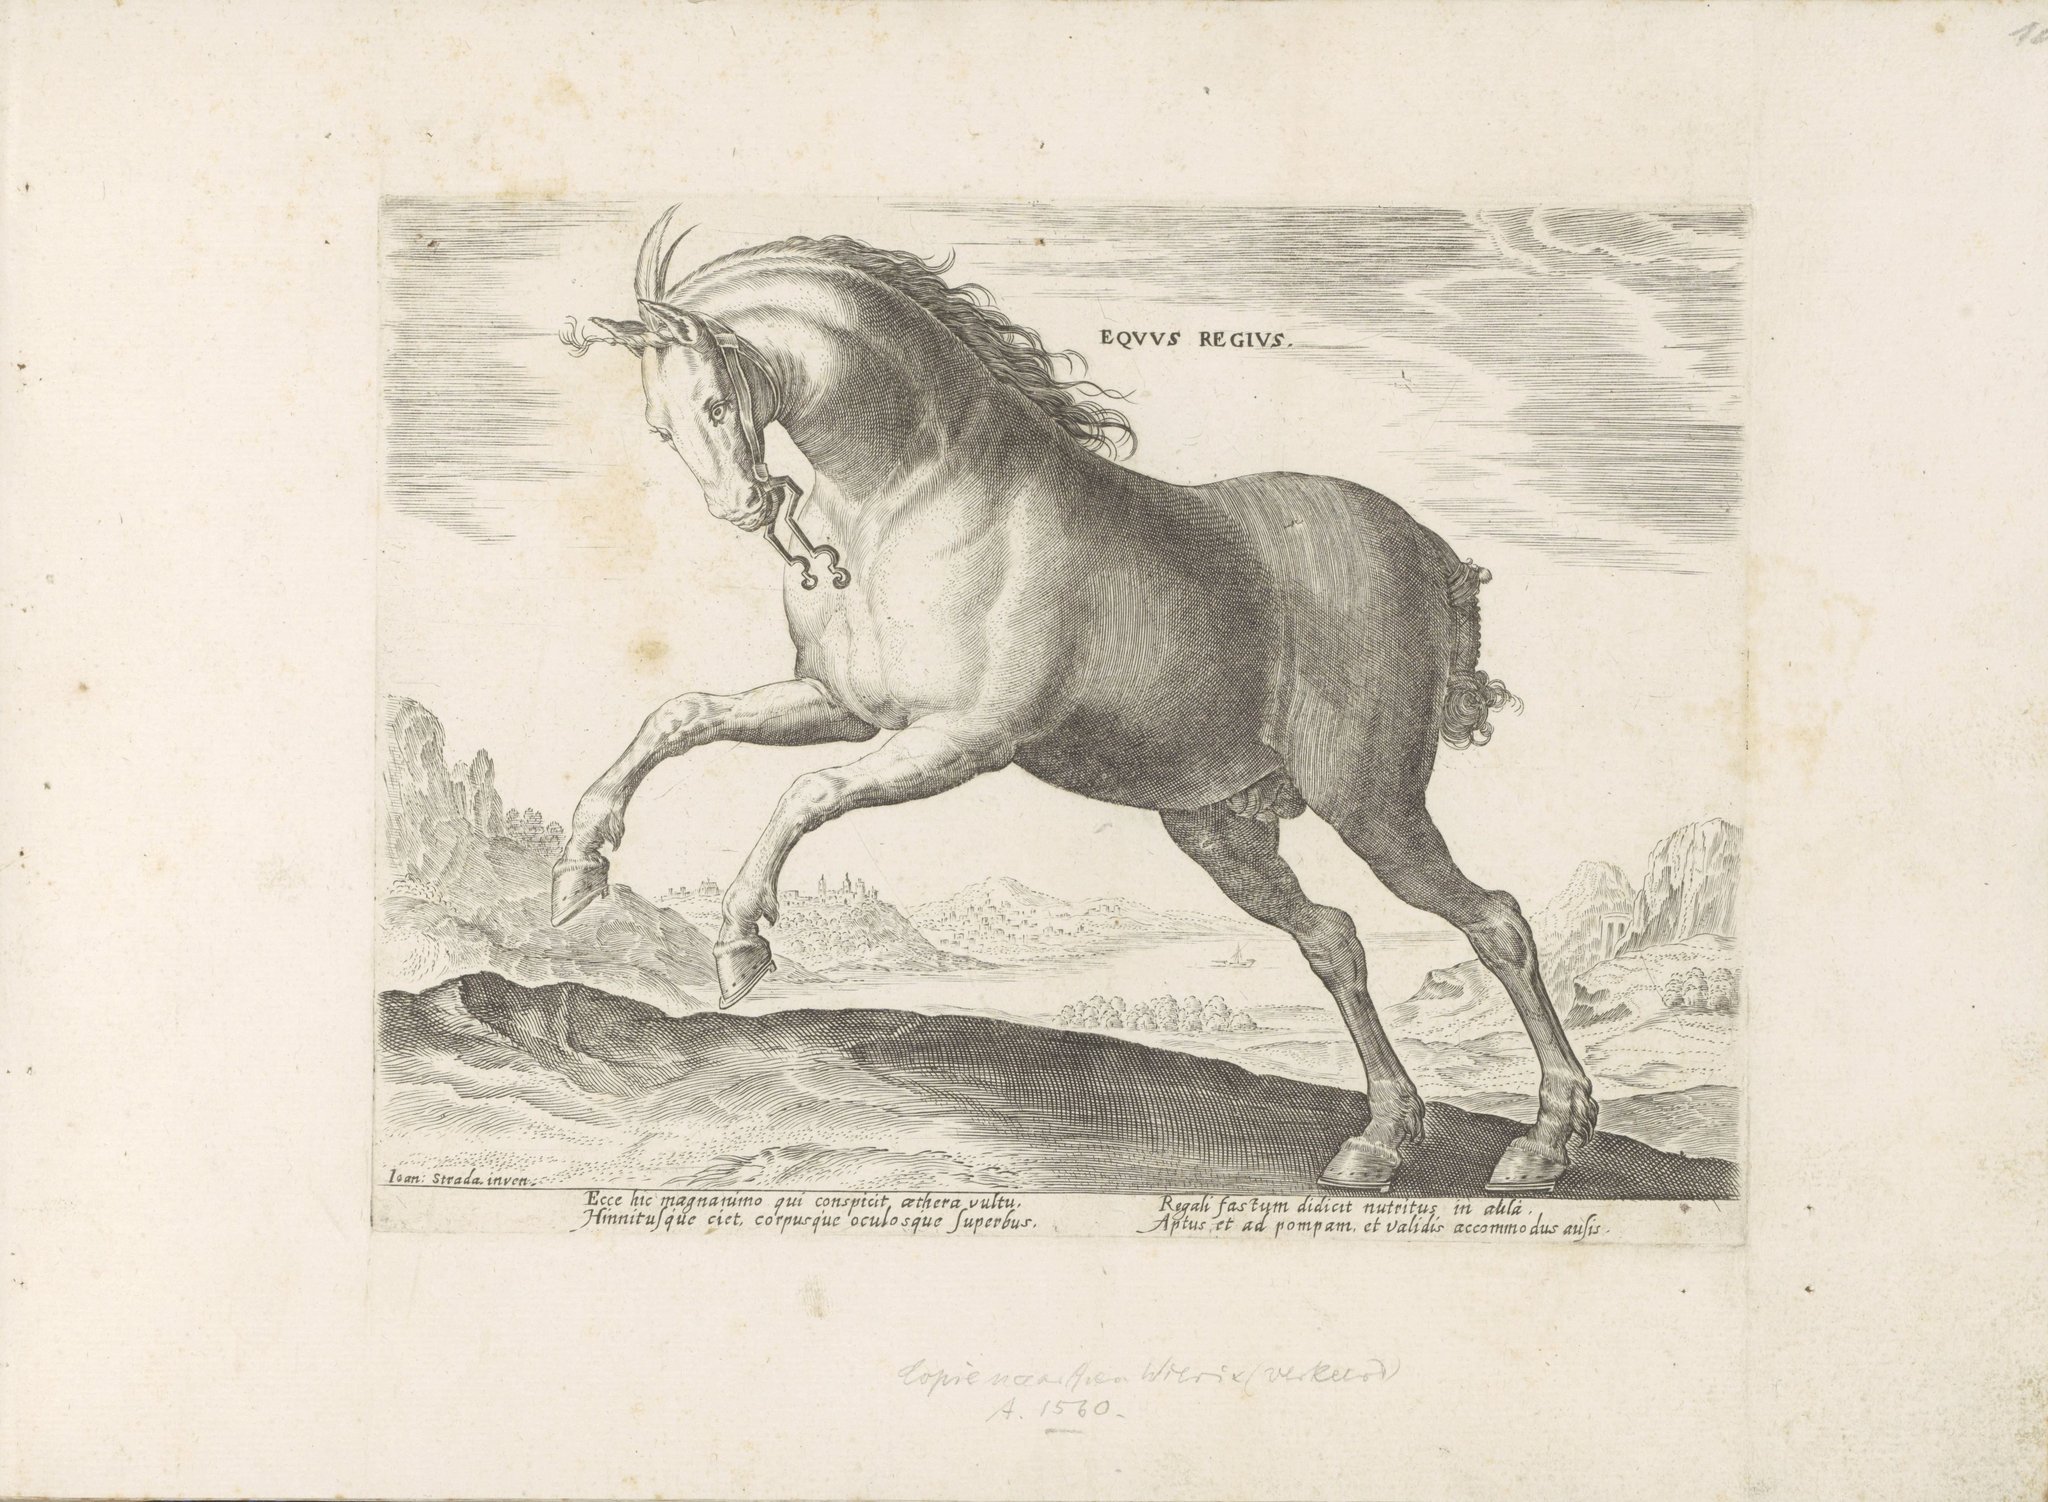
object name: print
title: Paard van het ras Equus Regius (de Koninklijke)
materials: paper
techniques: engraving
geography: venice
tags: don juan van oostenrijk, horses and kindred animals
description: Een paard van het koninklijke ras. Prent maakt deel uit van een album.